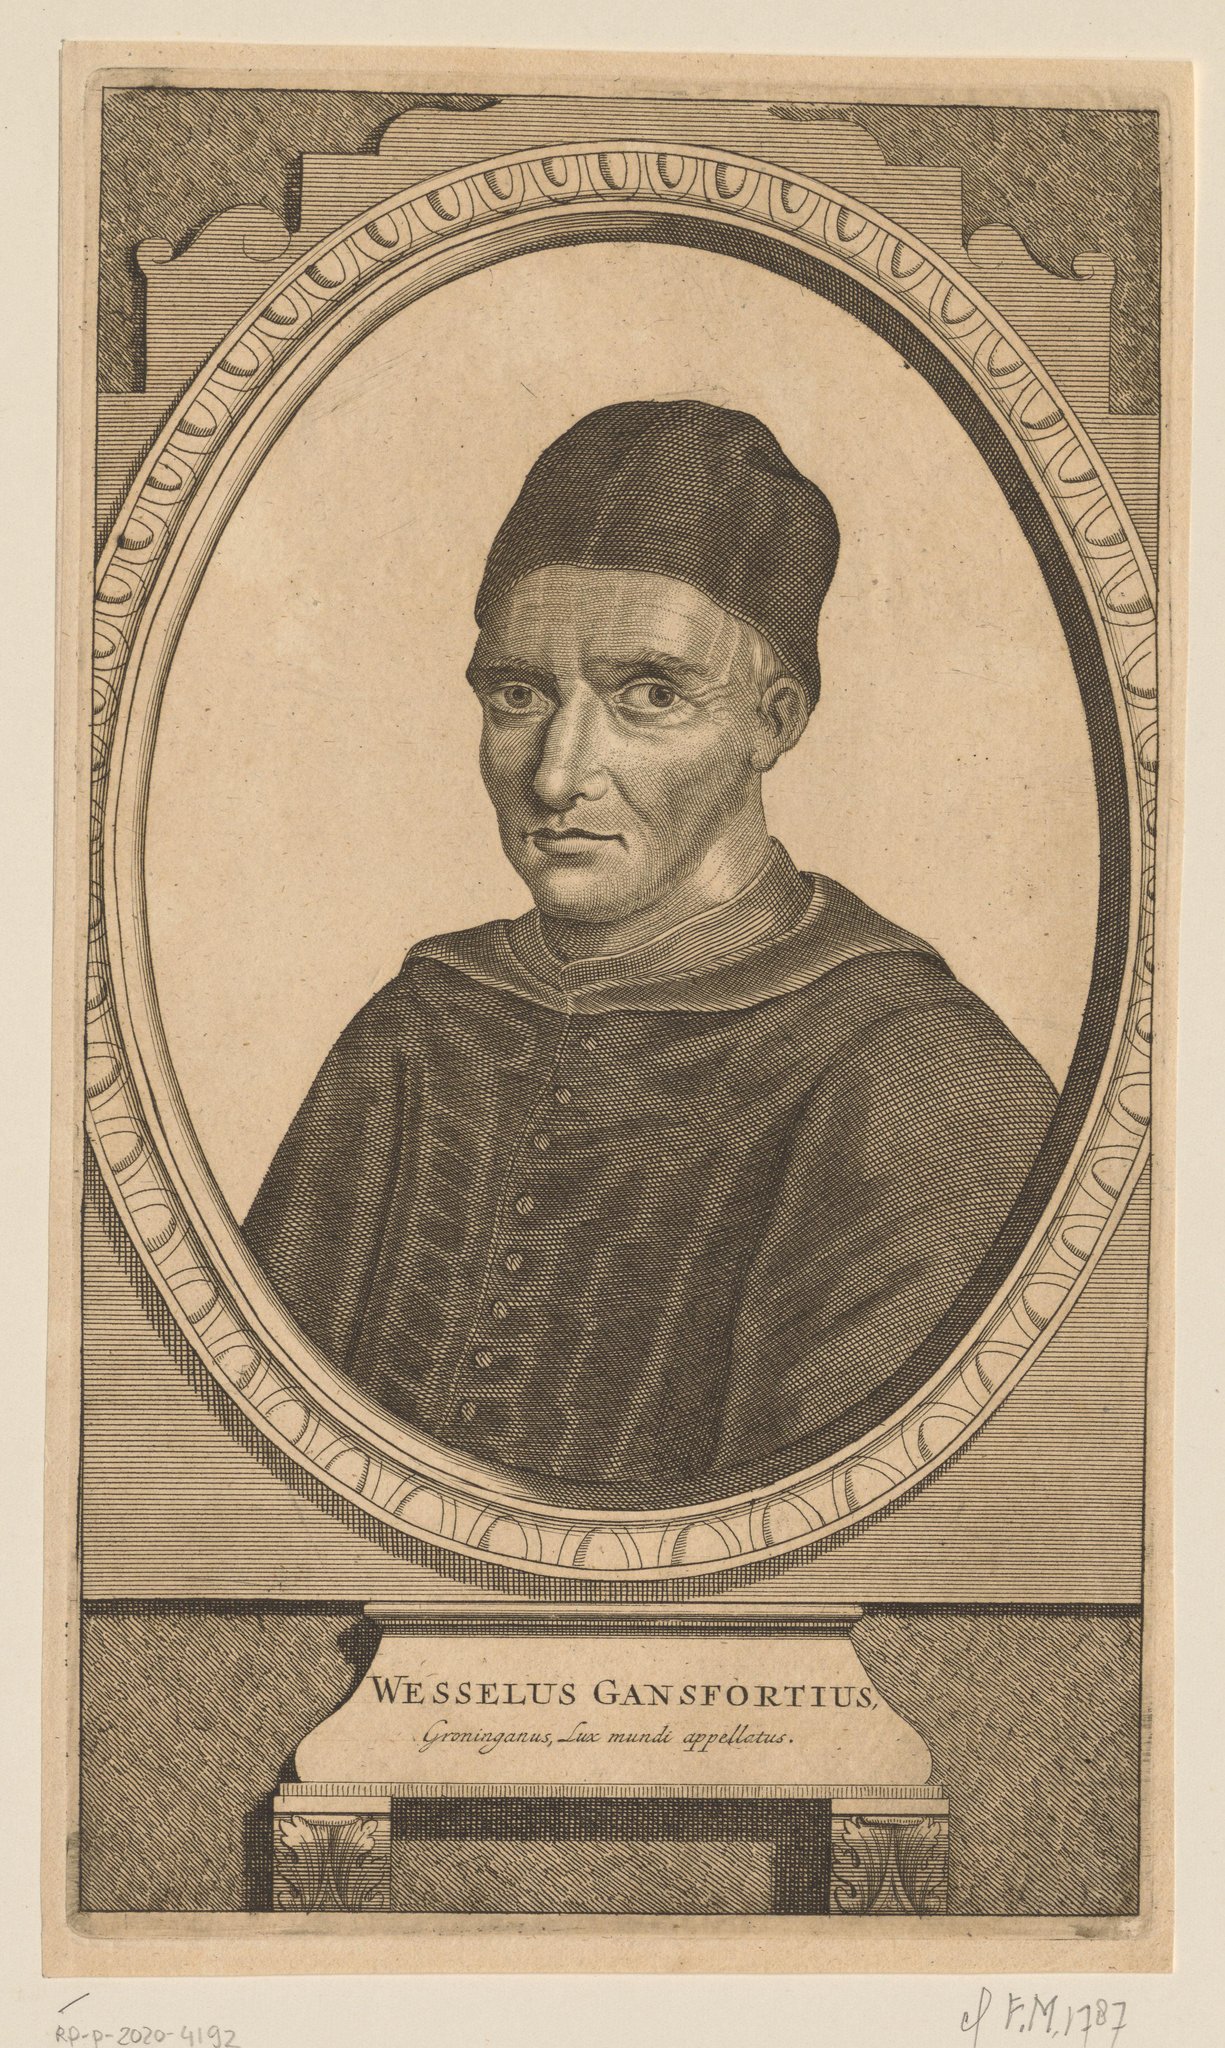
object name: print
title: Portret van Johann Wessel Gansfort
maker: Anonymous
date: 1700-1742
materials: paper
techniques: engraving, etching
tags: theologian, historical persons